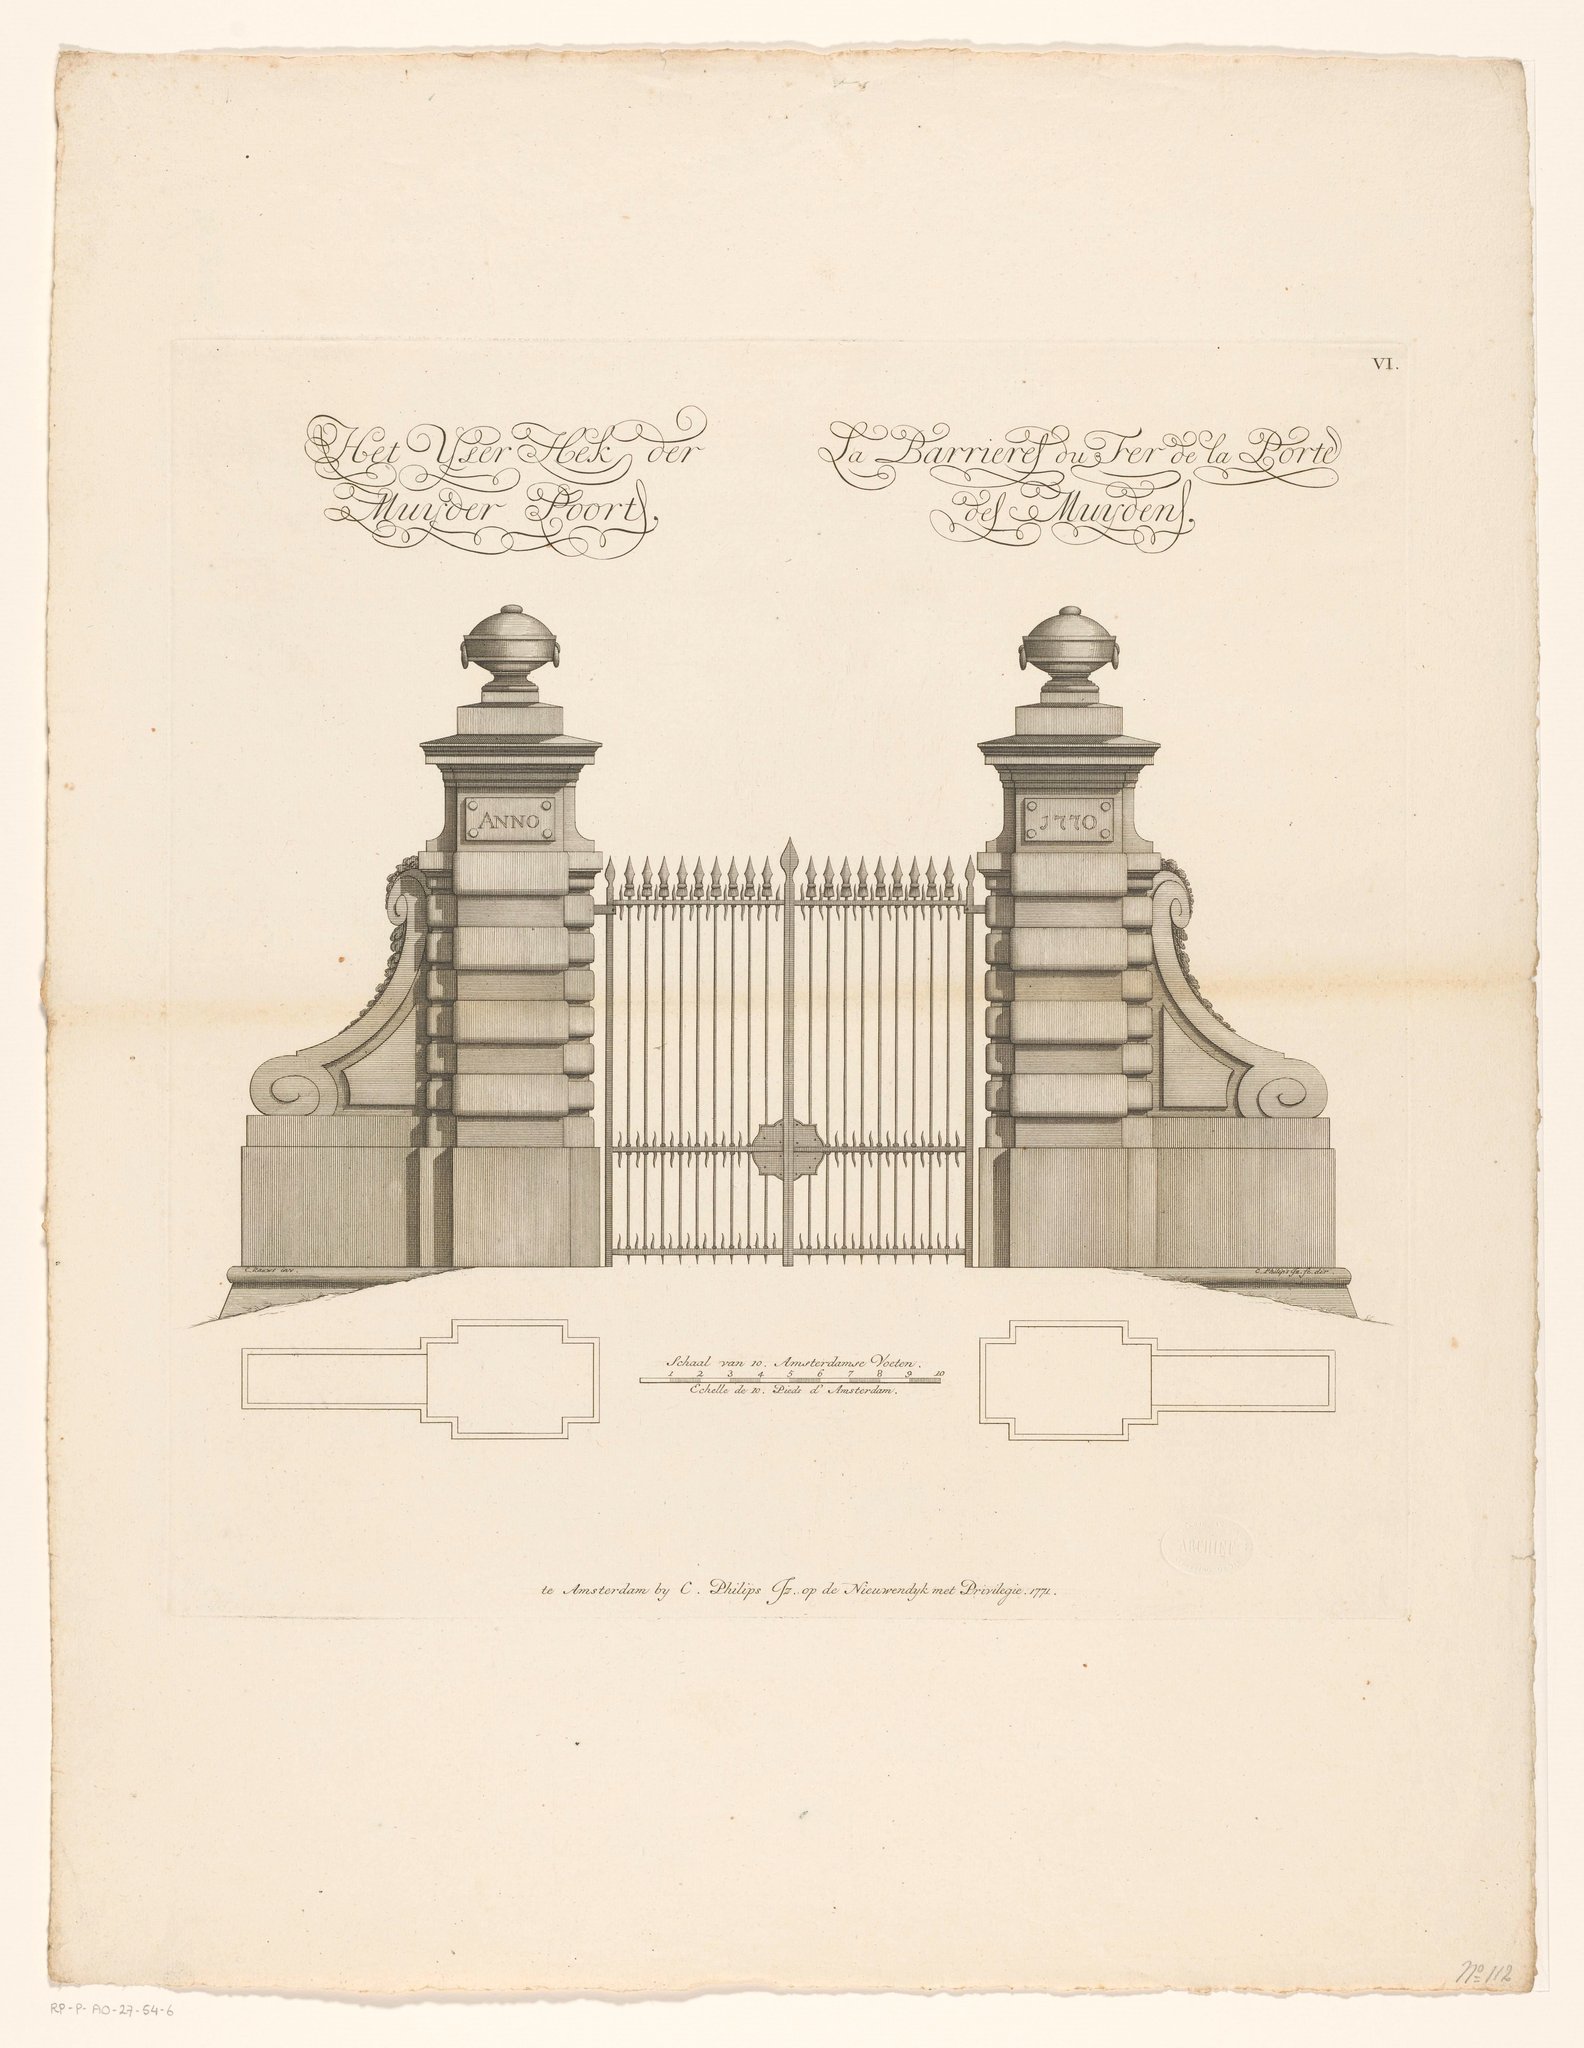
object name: print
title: Hek van de Tweede Muiderpoort te Amsterdam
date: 1771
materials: paper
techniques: engraving, etching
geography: amsterdam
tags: gate, entrance, series of designs, models, etc. of one architectural project, city-gate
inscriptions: check stamp: ‘Archief Ministerie van Oorlog Afdeeling Genie’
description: Het ijzeren hek van de Tweede Muiderpoort te Amsterdam, voor bij de toegangsbrug. Boven de titel in het Nederlands en Frans. Onder een schaalstok: Schaal van 10. Amsterdamse Voeten / Echelle de 10. Pieds d'Amsterdam. Rechtsboven genummerd: VI. Onderdeel van een serie van zes prenten van de Tweede Muiderpoort, gemaakt naar de ontwerptekeningen van stadsbouwmeester Cornelis Rauws. Deze stadspoort werd in 1770 gebouwd nadat de Eerste Muiderpoort in 1769 verzakte.